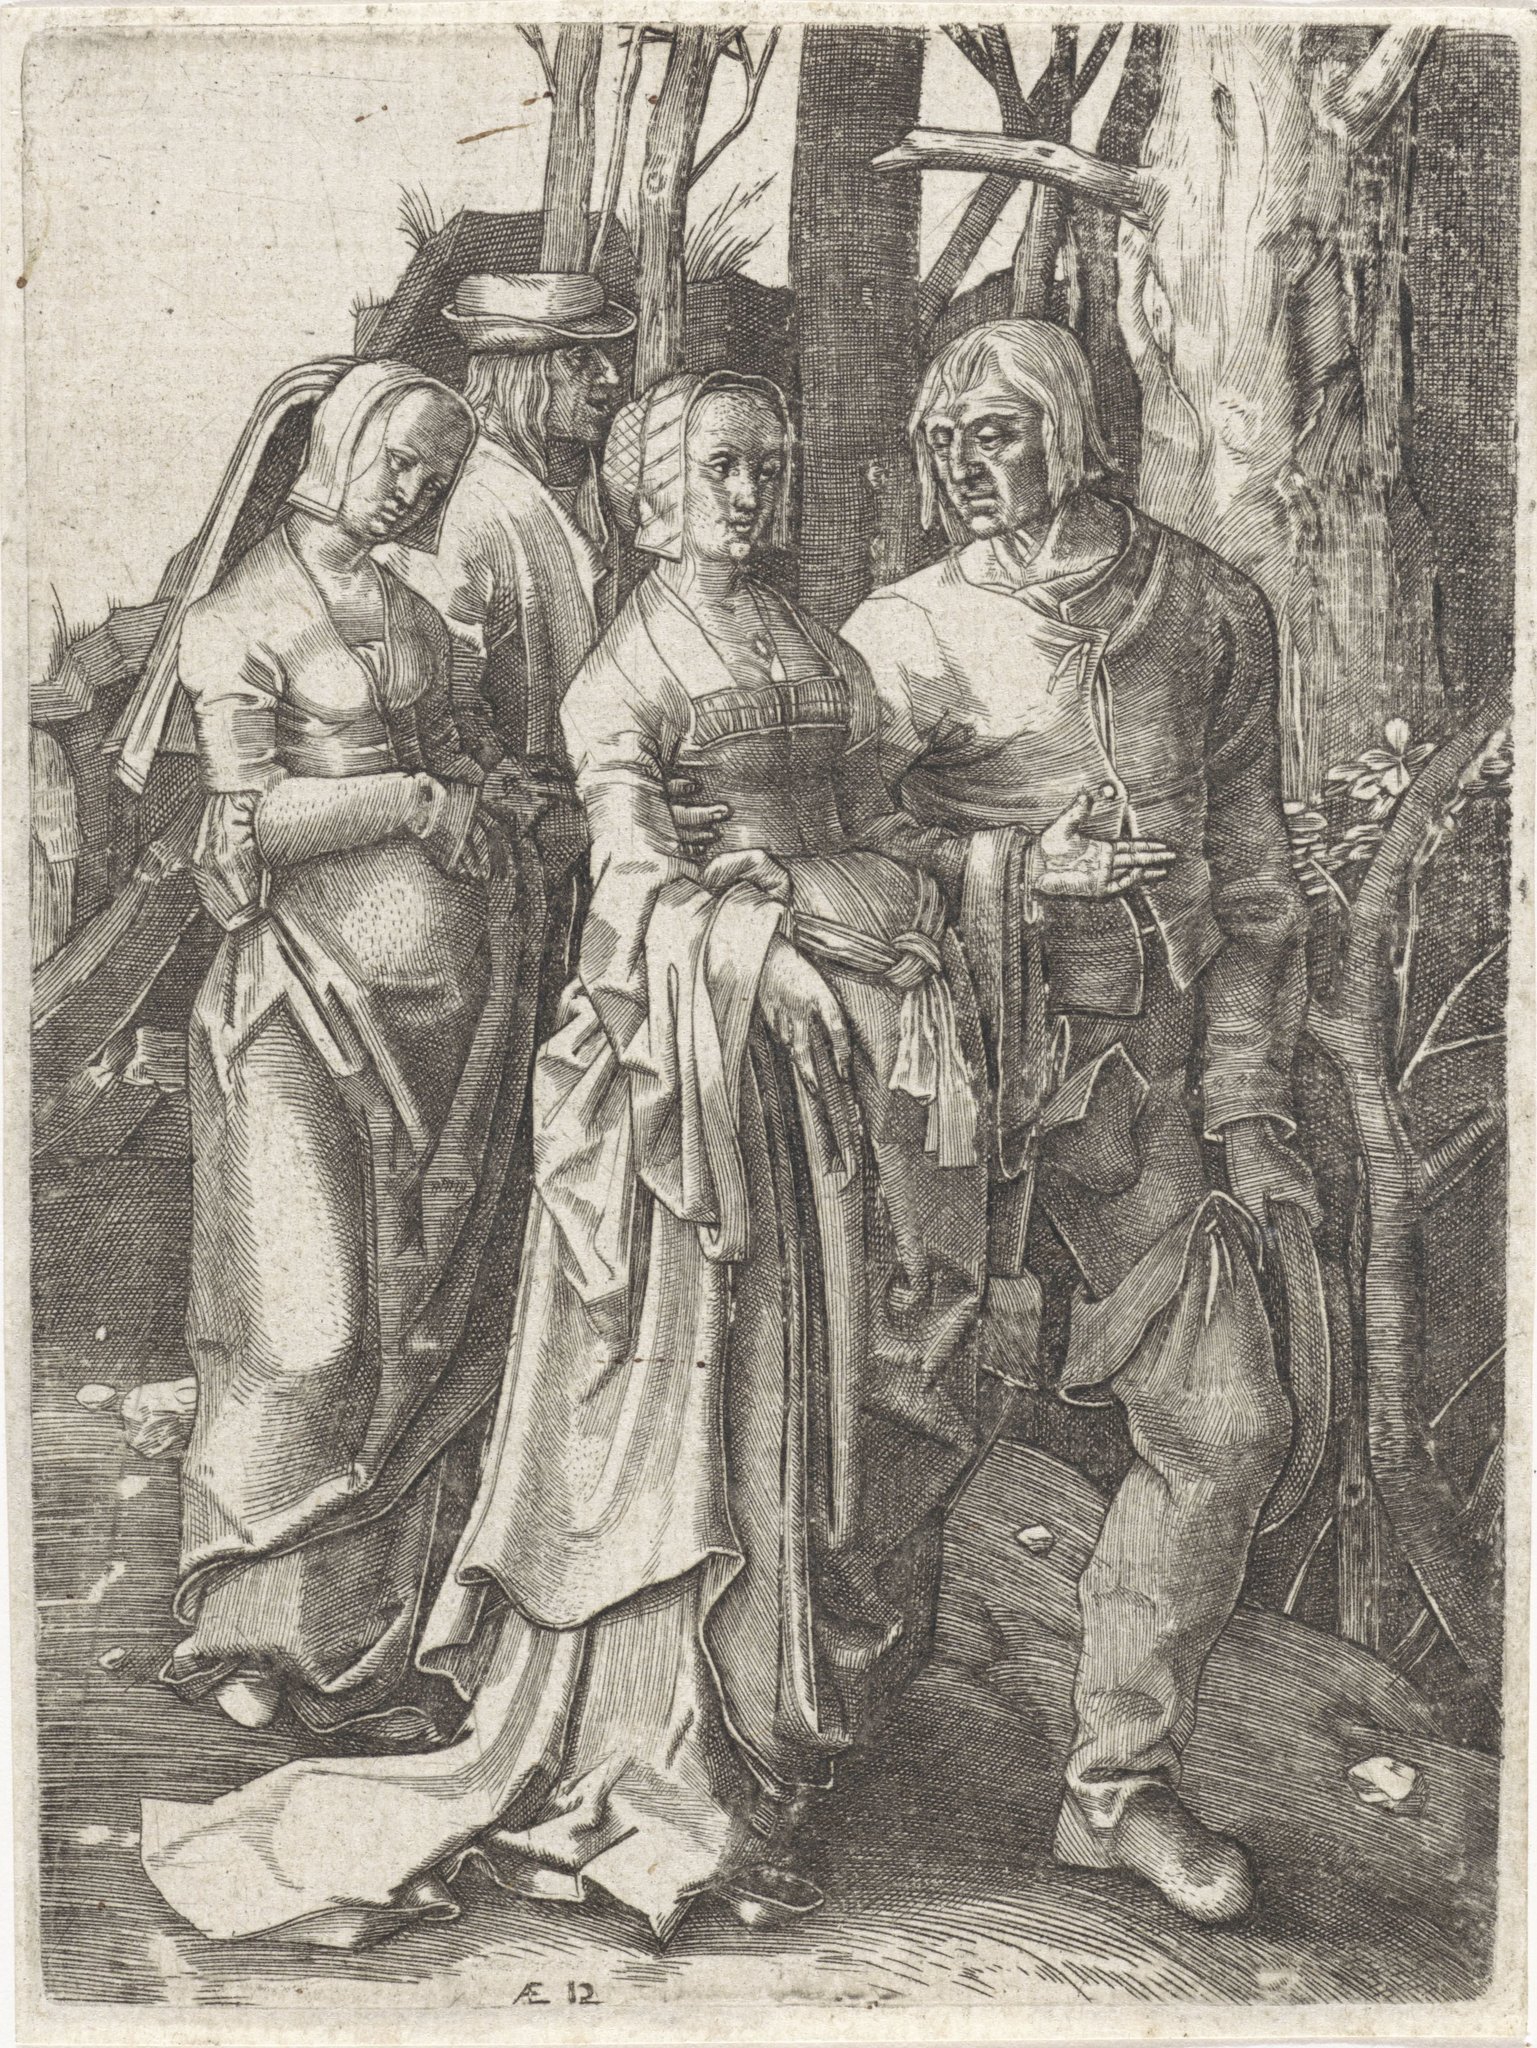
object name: print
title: Twee echtparen in het bos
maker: johannes wierix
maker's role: draughtsman, print maker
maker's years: 1549-1618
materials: paper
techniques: engraving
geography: antwerp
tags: bride and groom in wedding-dress, pacing, striding, forest, wood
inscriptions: collector's mark: Lugt 2228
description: Twee wandelende echtparen in het bos, gekleed volgens de mode van 1505-1515. Onderaan gesigneerd "Æ12".